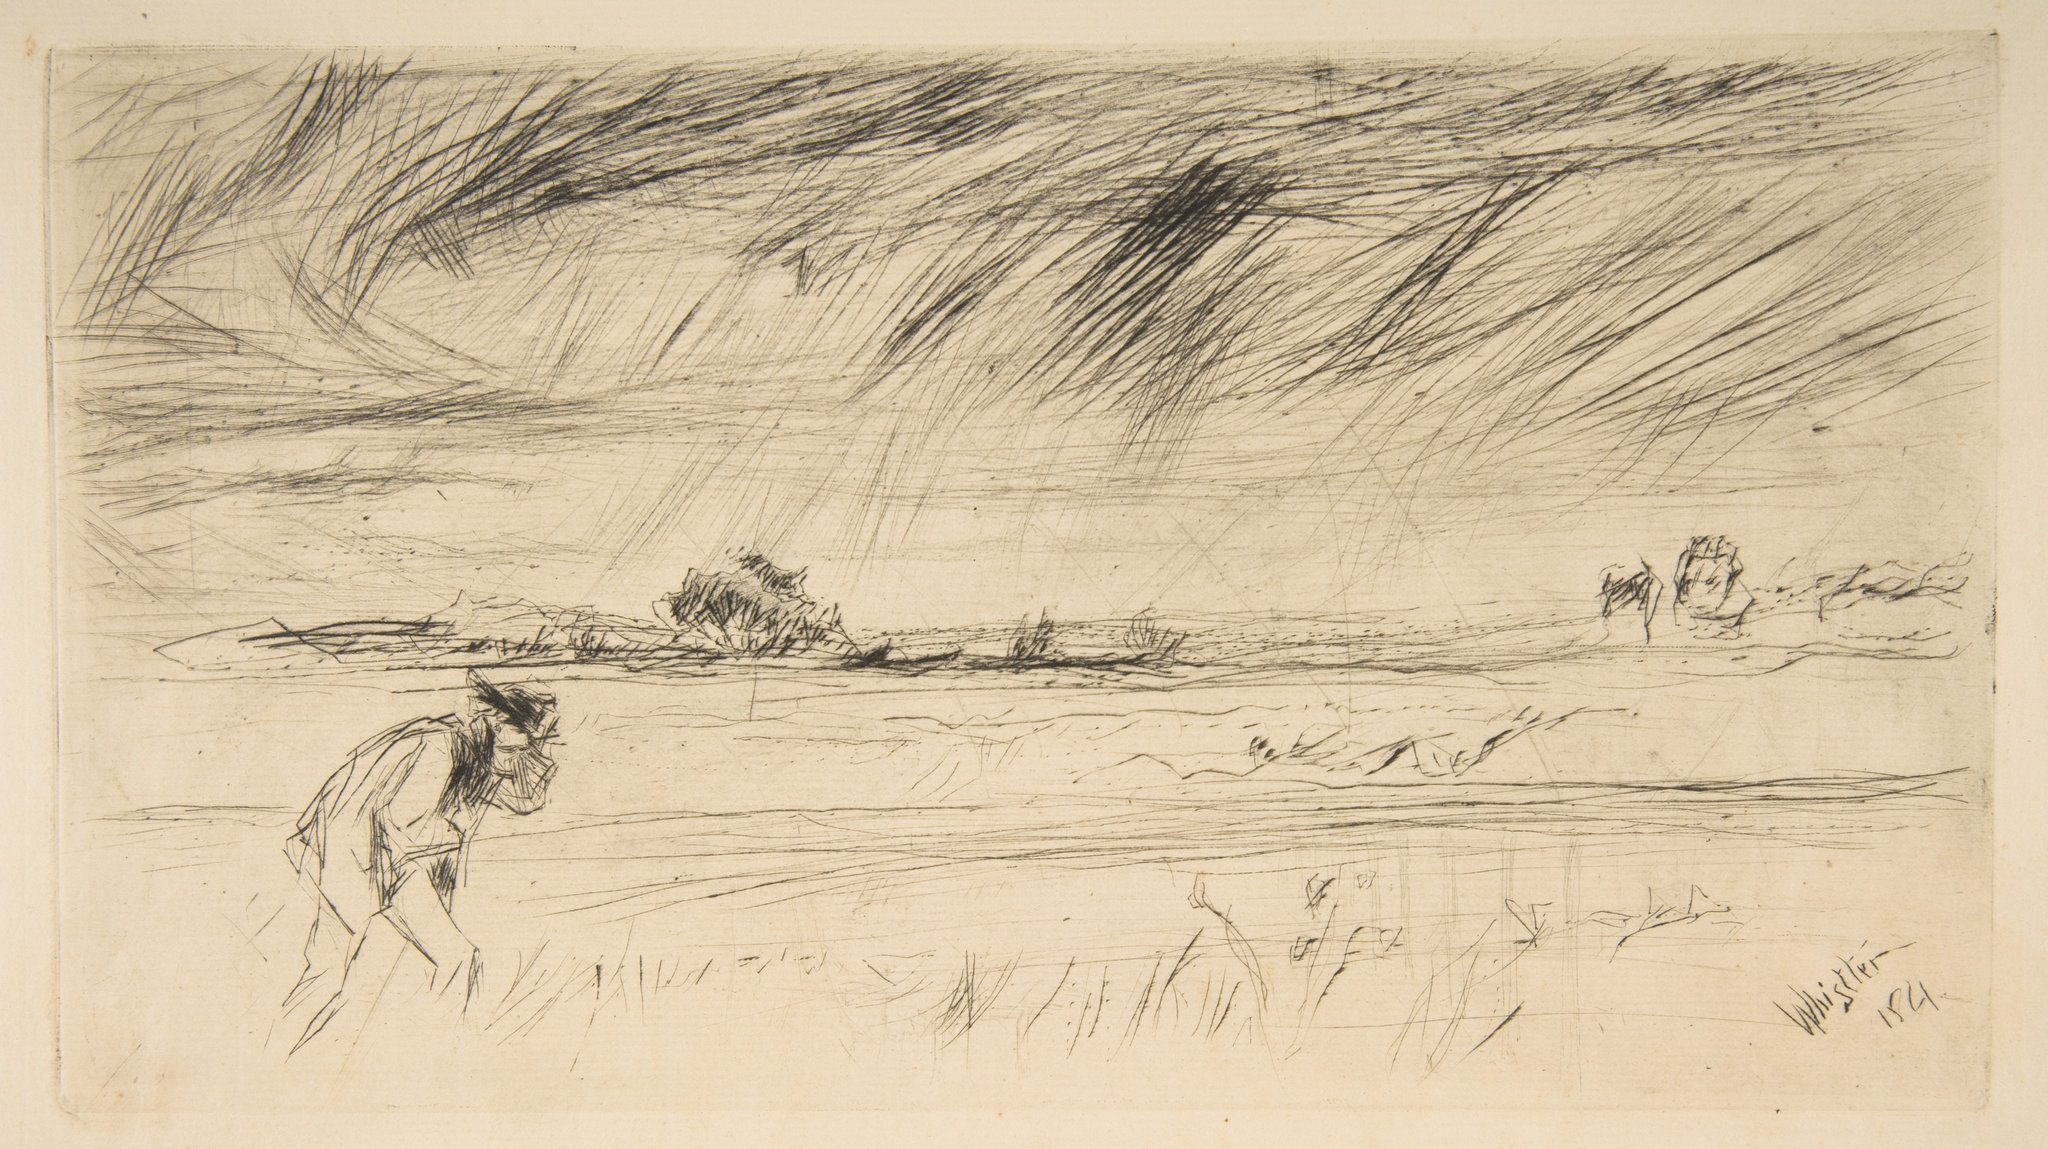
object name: print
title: The Storm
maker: james mcneill whistler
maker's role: artist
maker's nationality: american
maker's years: 1834-1903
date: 1861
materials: ink, paper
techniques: drypoint, printing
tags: men,storms